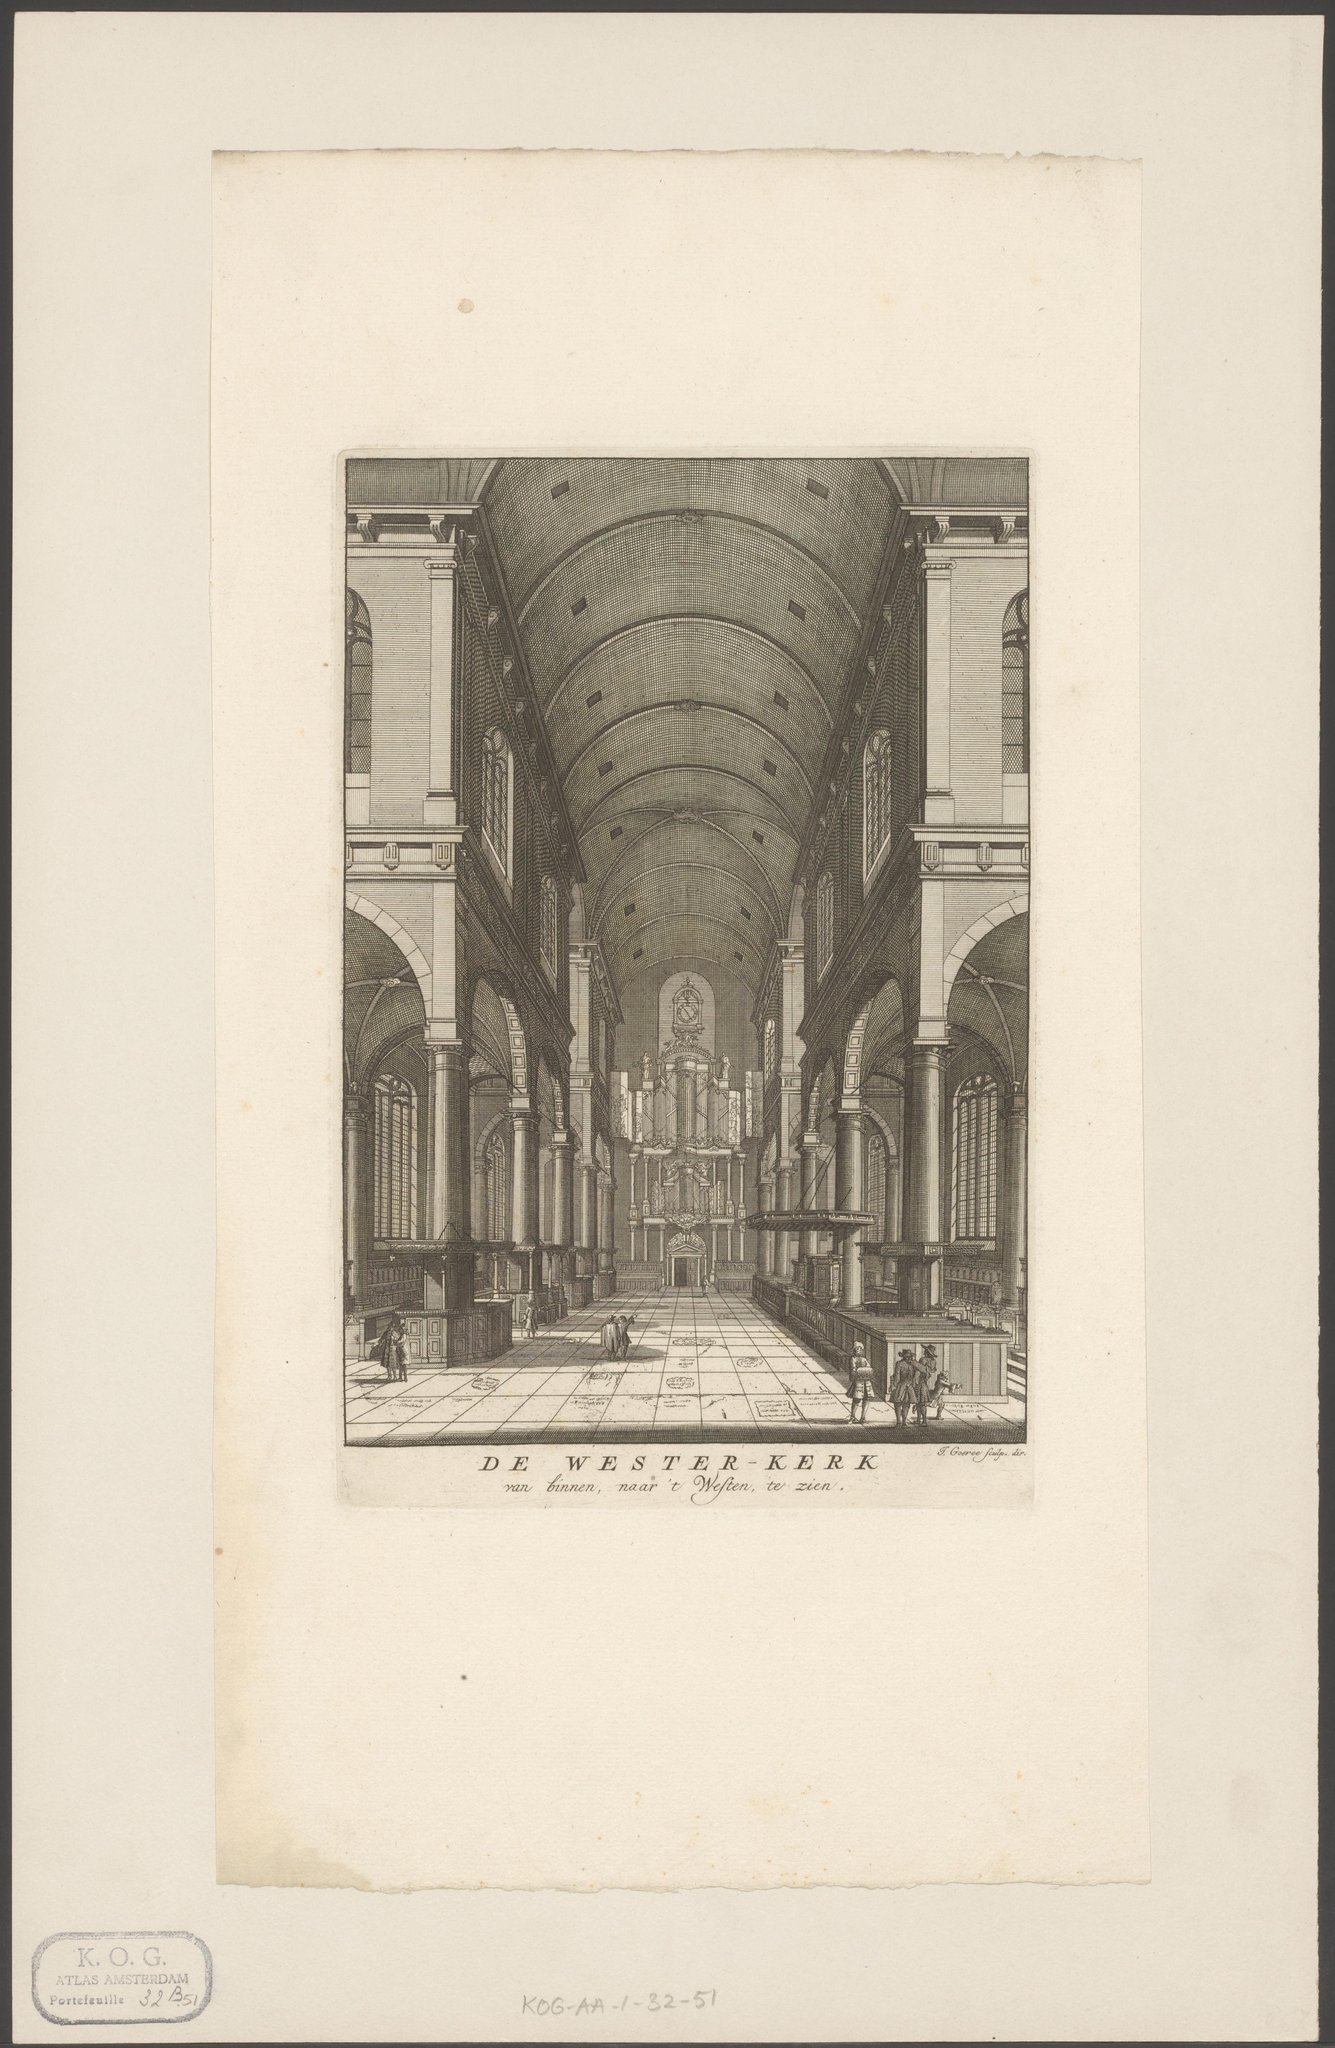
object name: print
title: De Wester-kerk van binnen, naar 't Westen, te zien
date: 1680-1731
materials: paper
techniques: engraving, etching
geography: amsterdam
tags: church organ, interior of church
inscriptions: collector's mark: ‘32B.51’ Lugt 1641b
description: Prent mogelijk uit: Wagenaar, Jan. Amsterdam, in zyne opkomst, aanwas, geschiedenissen (...). Amsterdam: Isaak Tirion, 1765, dl. 2, tussen 132-133.